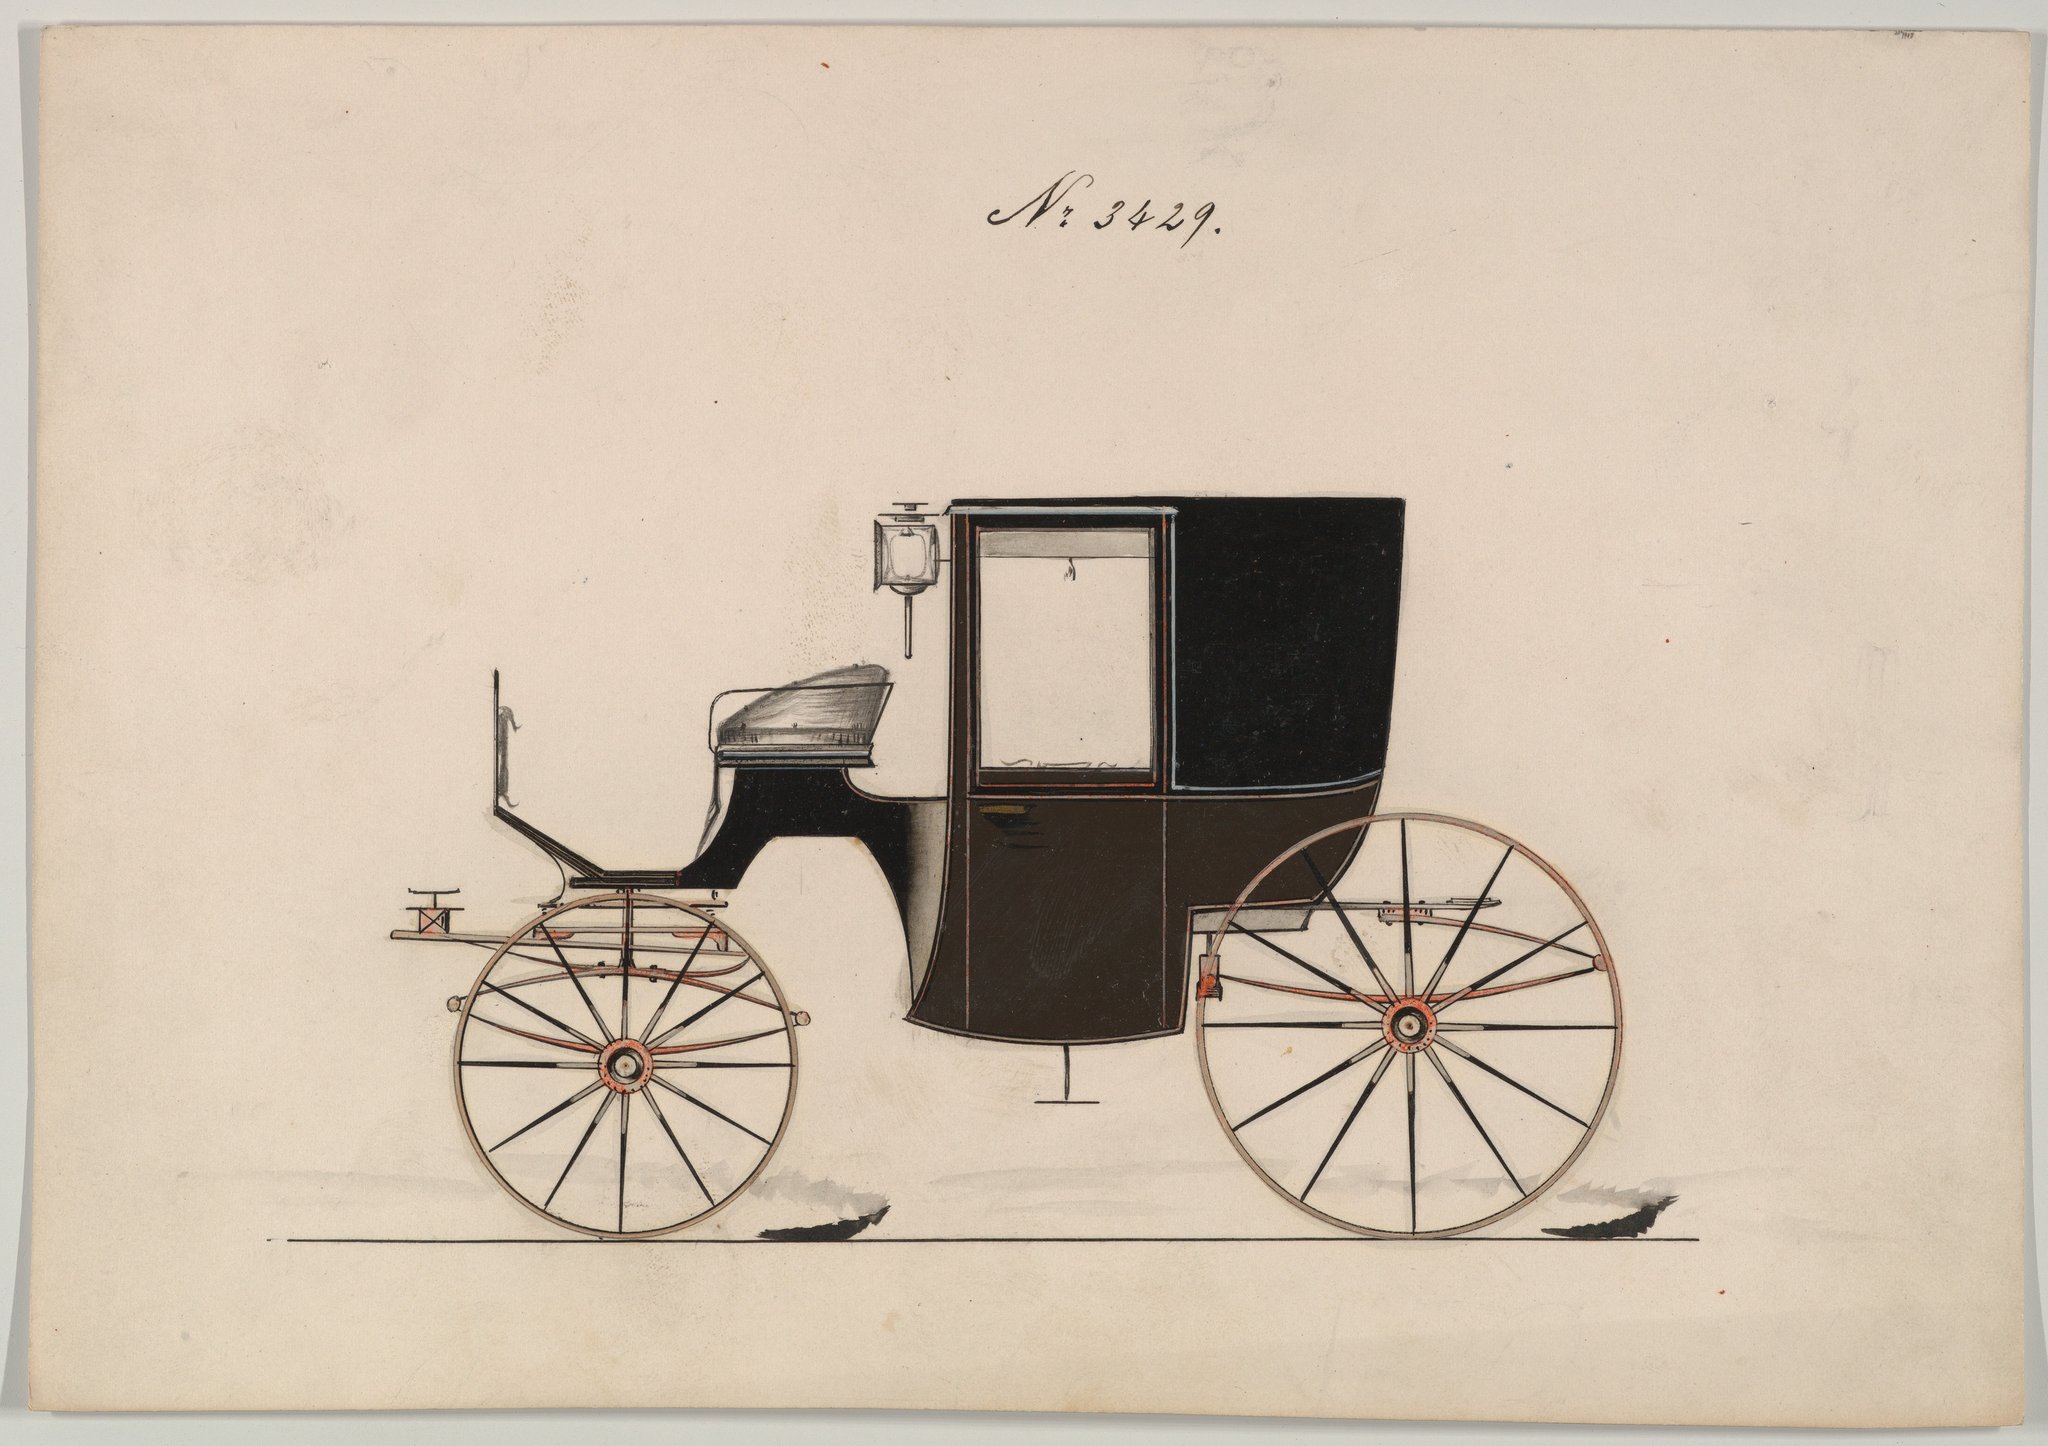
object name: drawing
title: Brougham #3429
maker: brewster & co.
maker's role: manufacturer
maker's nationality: american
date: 1878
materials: gouache, gum arabic, ink, watercolor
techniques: pen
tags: carriages